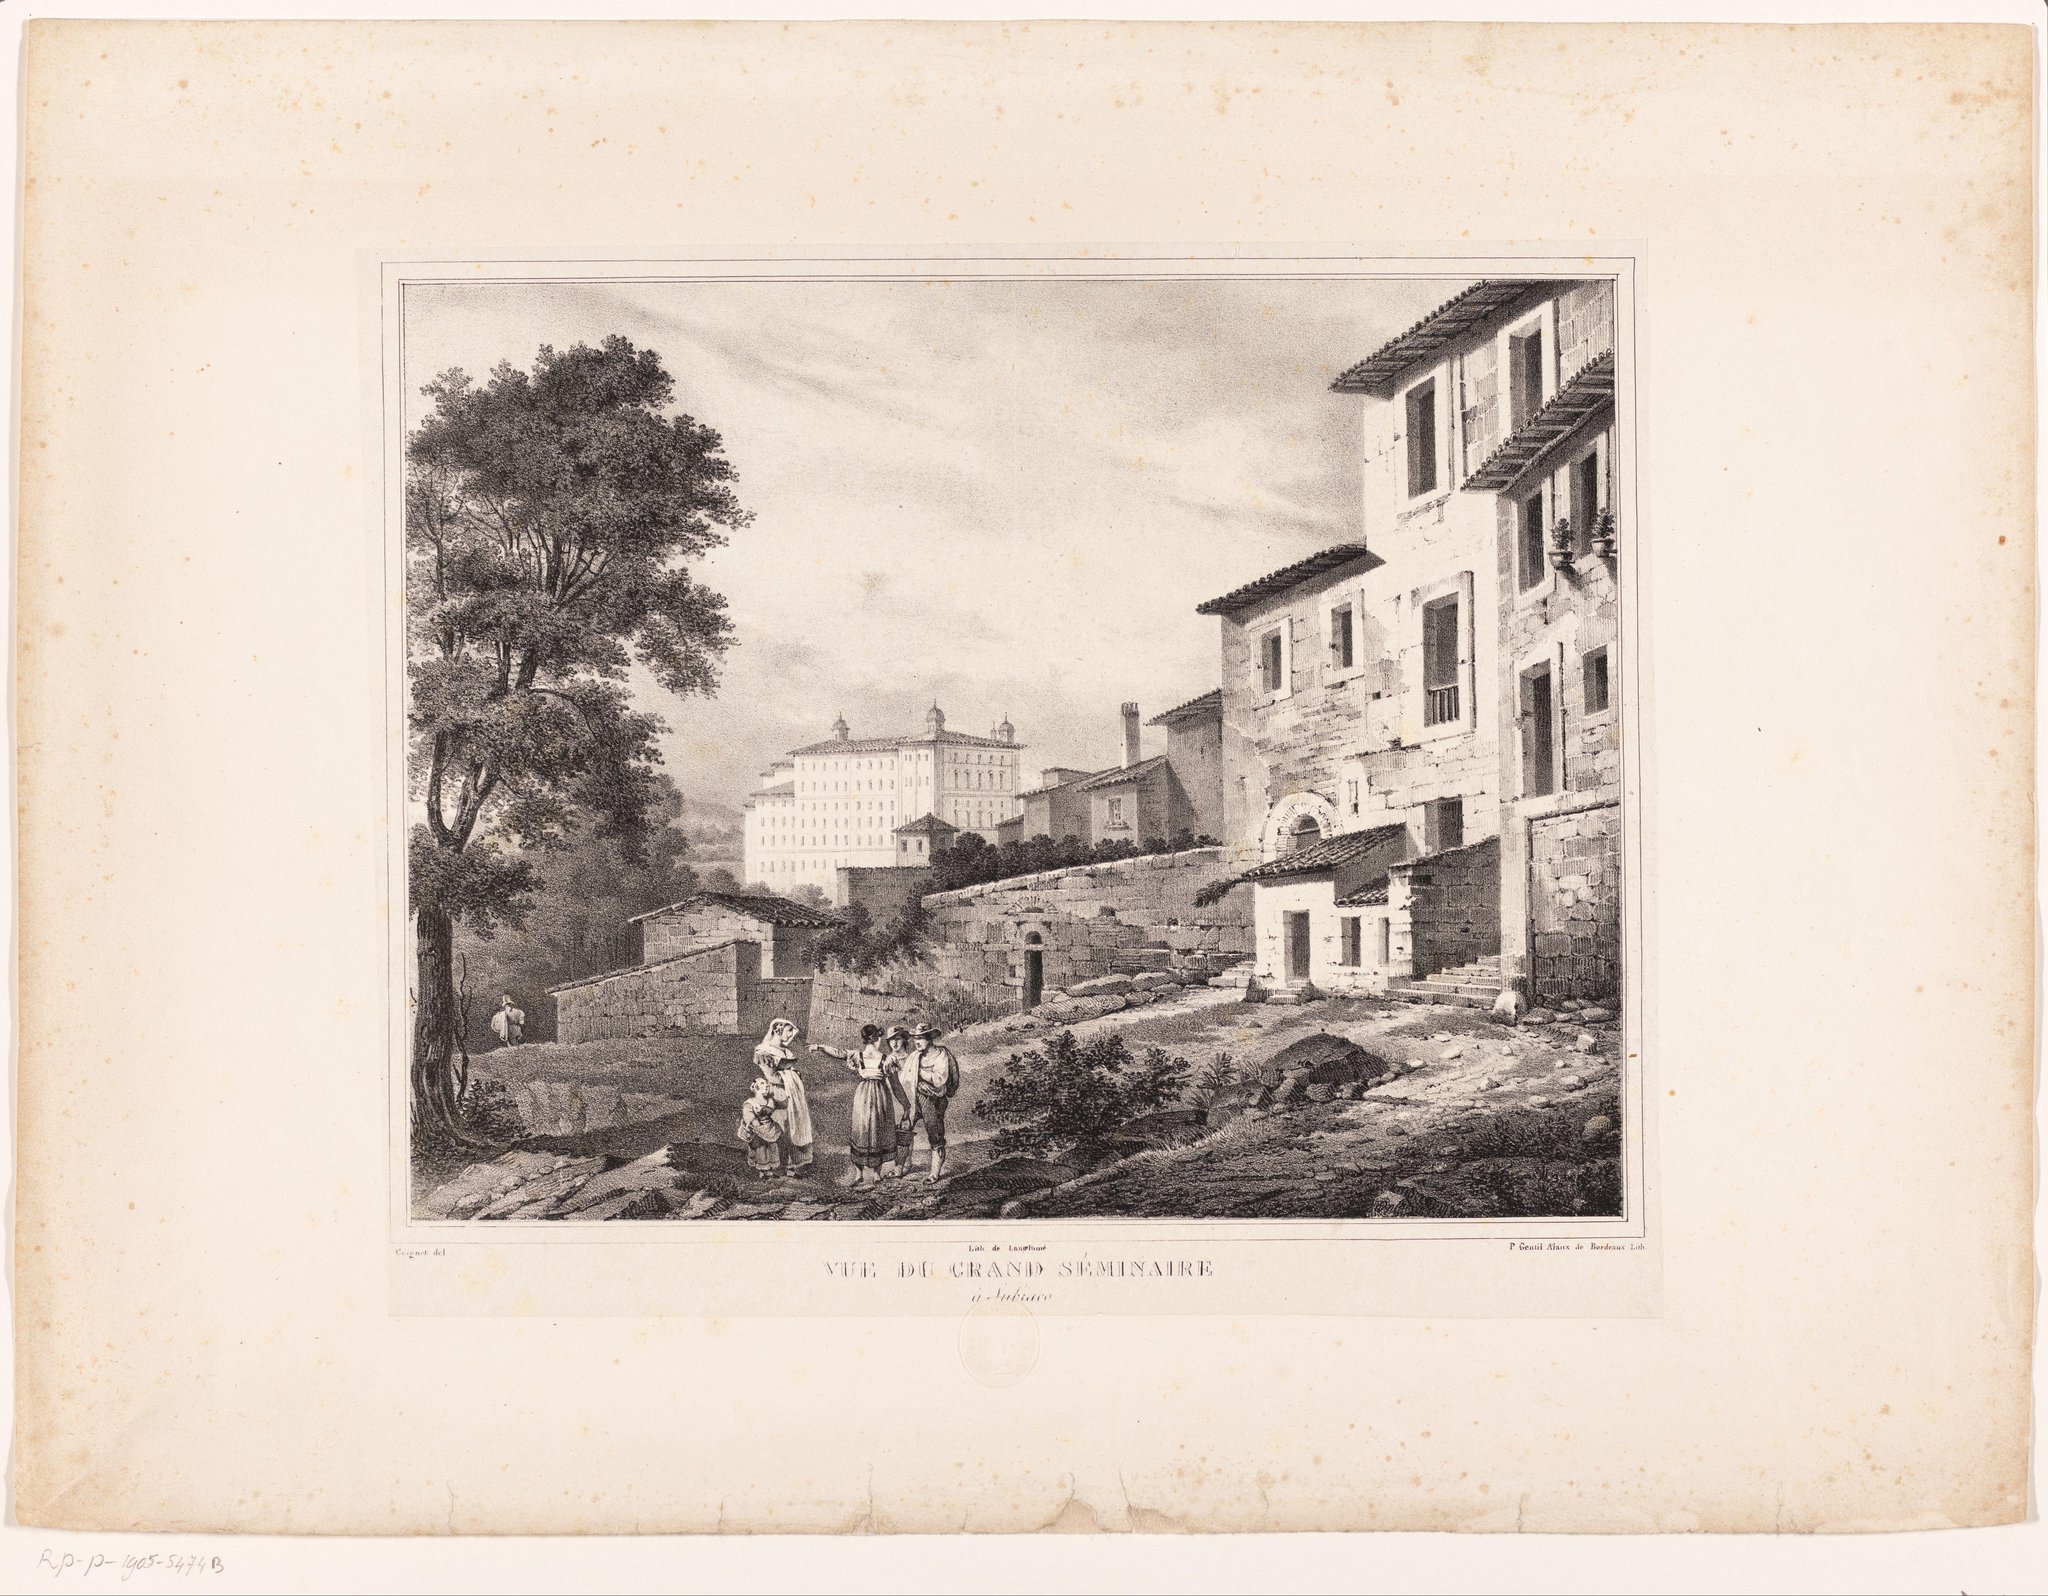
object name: print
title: Zicht op het grootseminarie te Subiaco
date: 1824-1826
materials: paper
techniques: lithography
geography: paris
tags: institution for ecclesiastical education and training, e.g. seminary, prospect of city, town panorama, silhouette of city (+ city(-scape) with figures, staffage)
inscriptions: collector's mark: Lugt 2228, check stamp: Lugt 3431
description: Op de voorgrond zijn drie vrouwen, een man en een kind met elkaar in gesprek. Op de achtergrond is het grootseminarie van Subiaco (Italië) te zien.